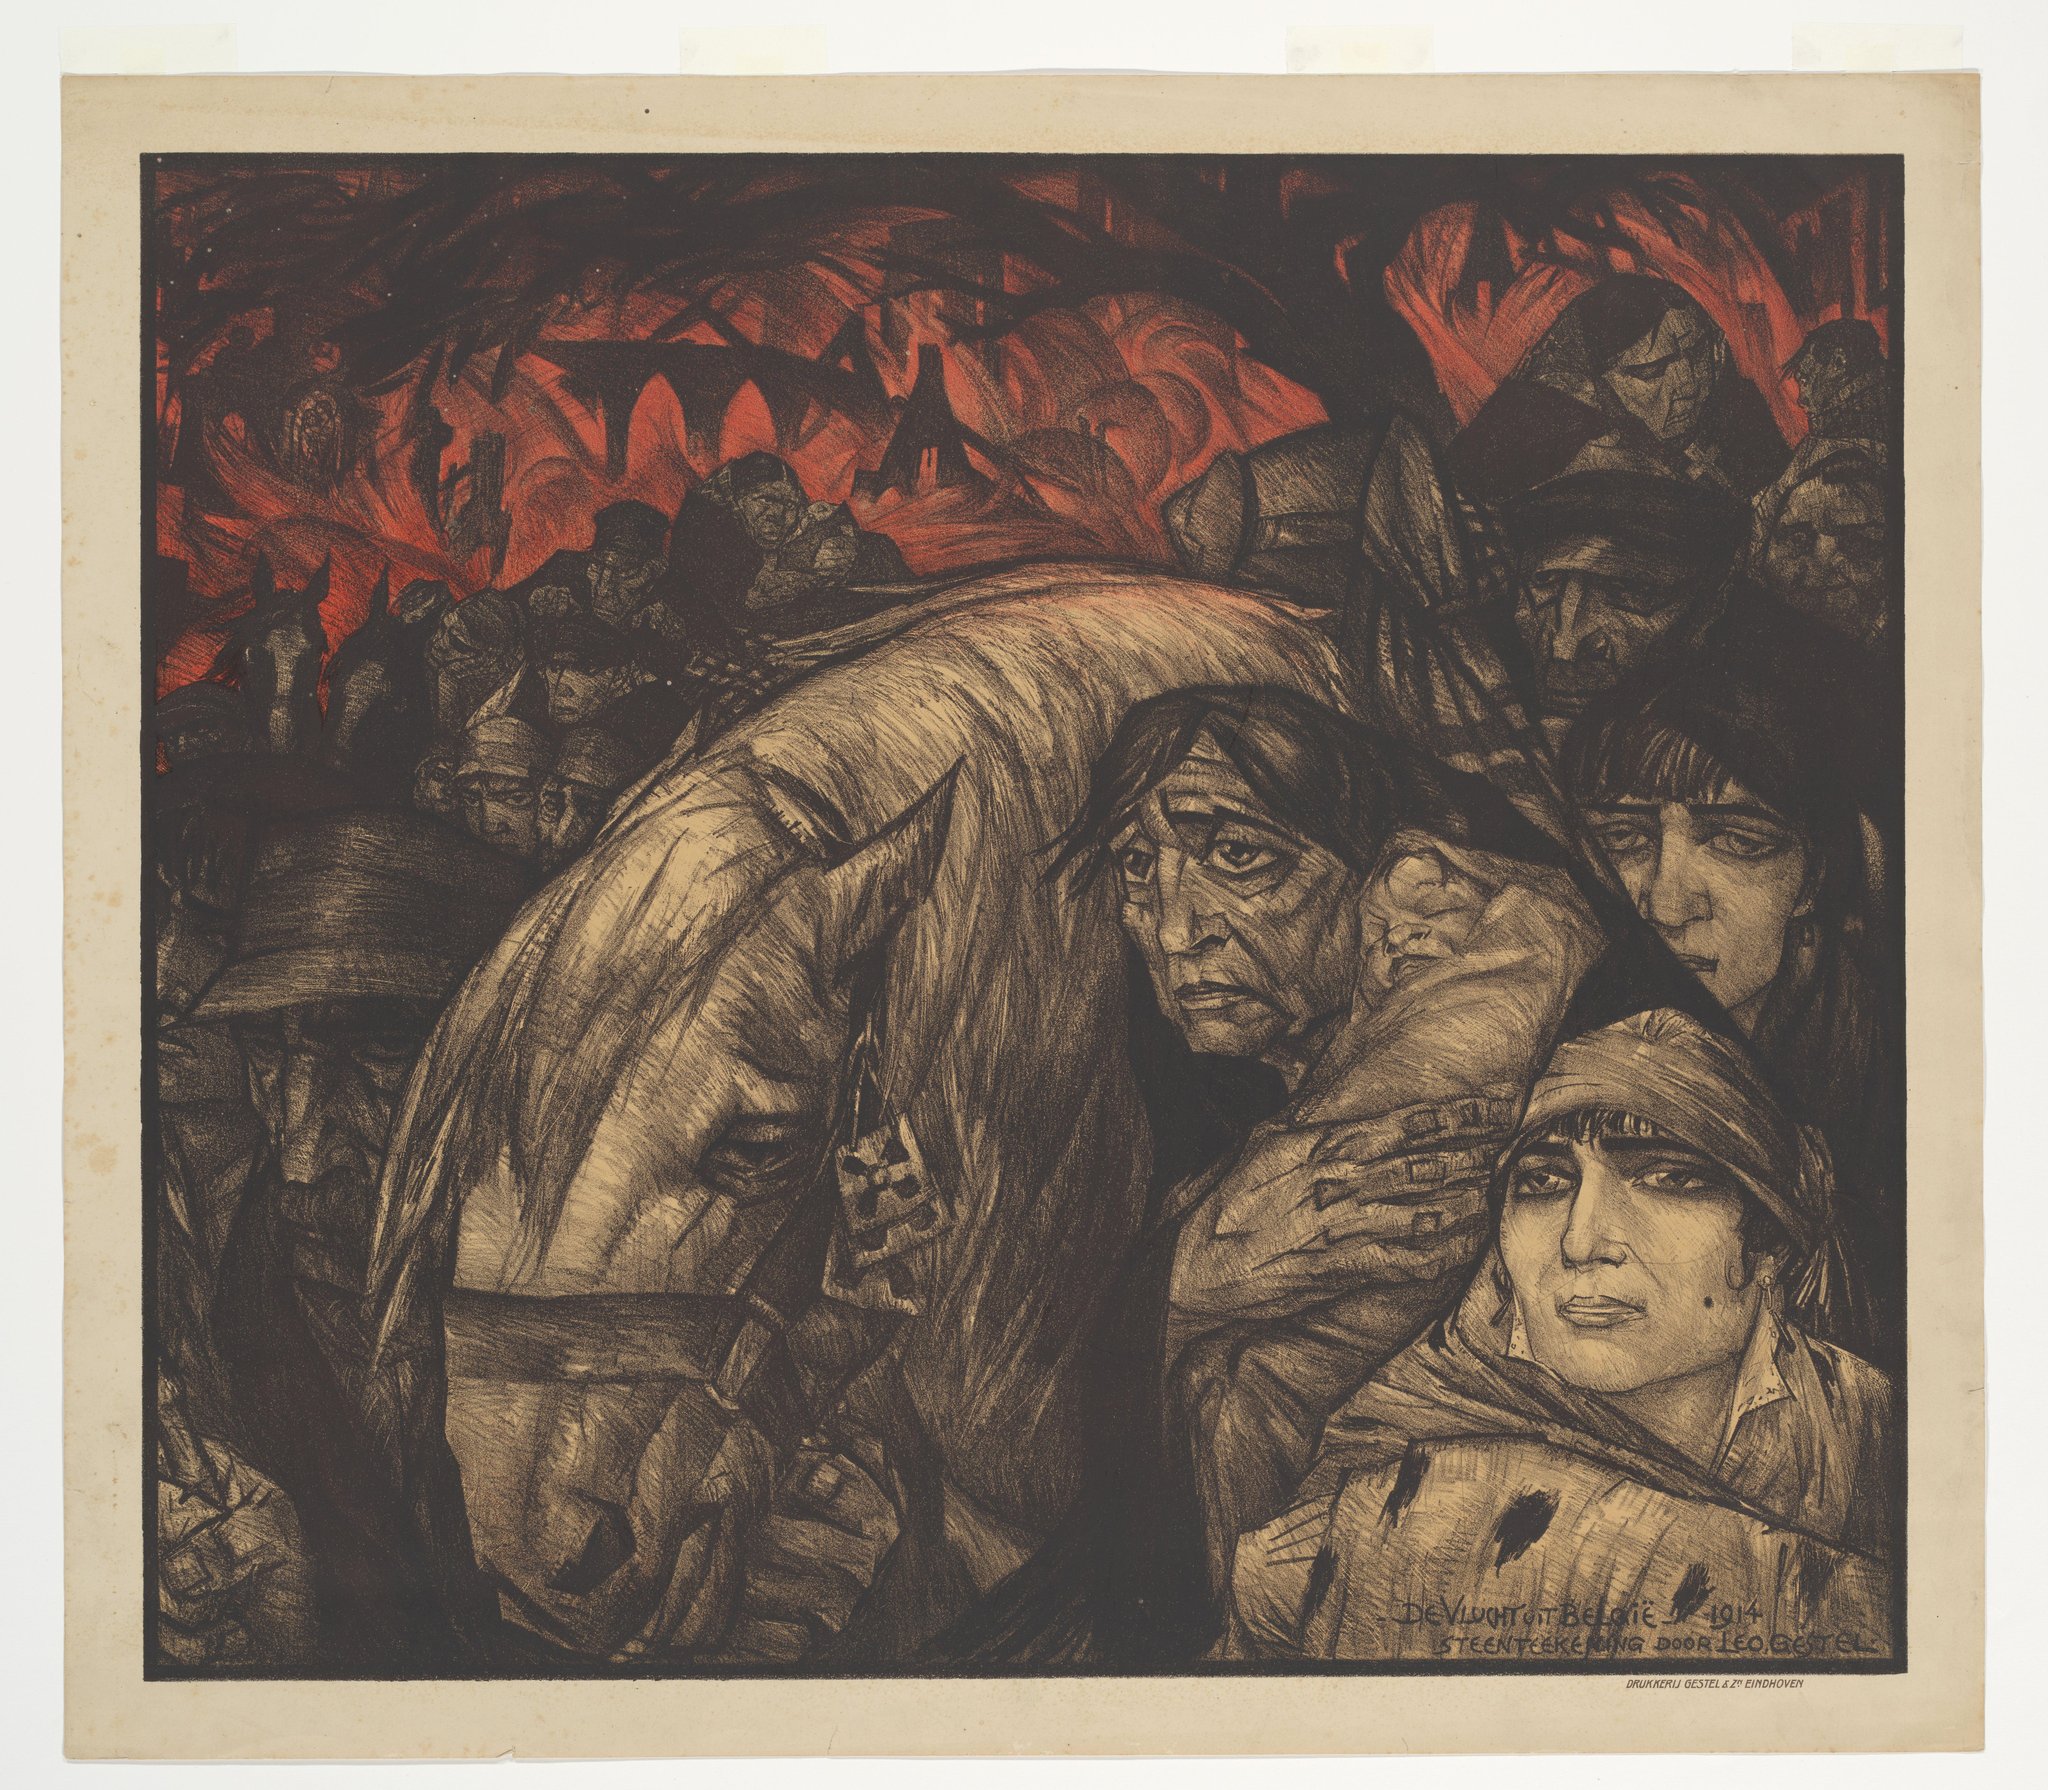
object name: print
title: De vlucht uit België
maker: leo gestel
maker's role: draughtsman, print maker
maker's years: 1881-1941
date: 1914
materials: paper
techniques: lithograph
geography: spain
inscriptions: signature and date: ‘1914 // LEO GESTEL’, workshop stamp: ‘DRUKKERIJ GESTEL & Zn EINHOVEN’, title: ‘De Vlucht vanuit België’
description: Optocht van mensen, in de voorste rij een paard met gebogen hals, frontaal weergeveven sombere gezichten, achter mensen in sterk verkleind perspectief weergegeven, een rode achtergrond bovenaan.